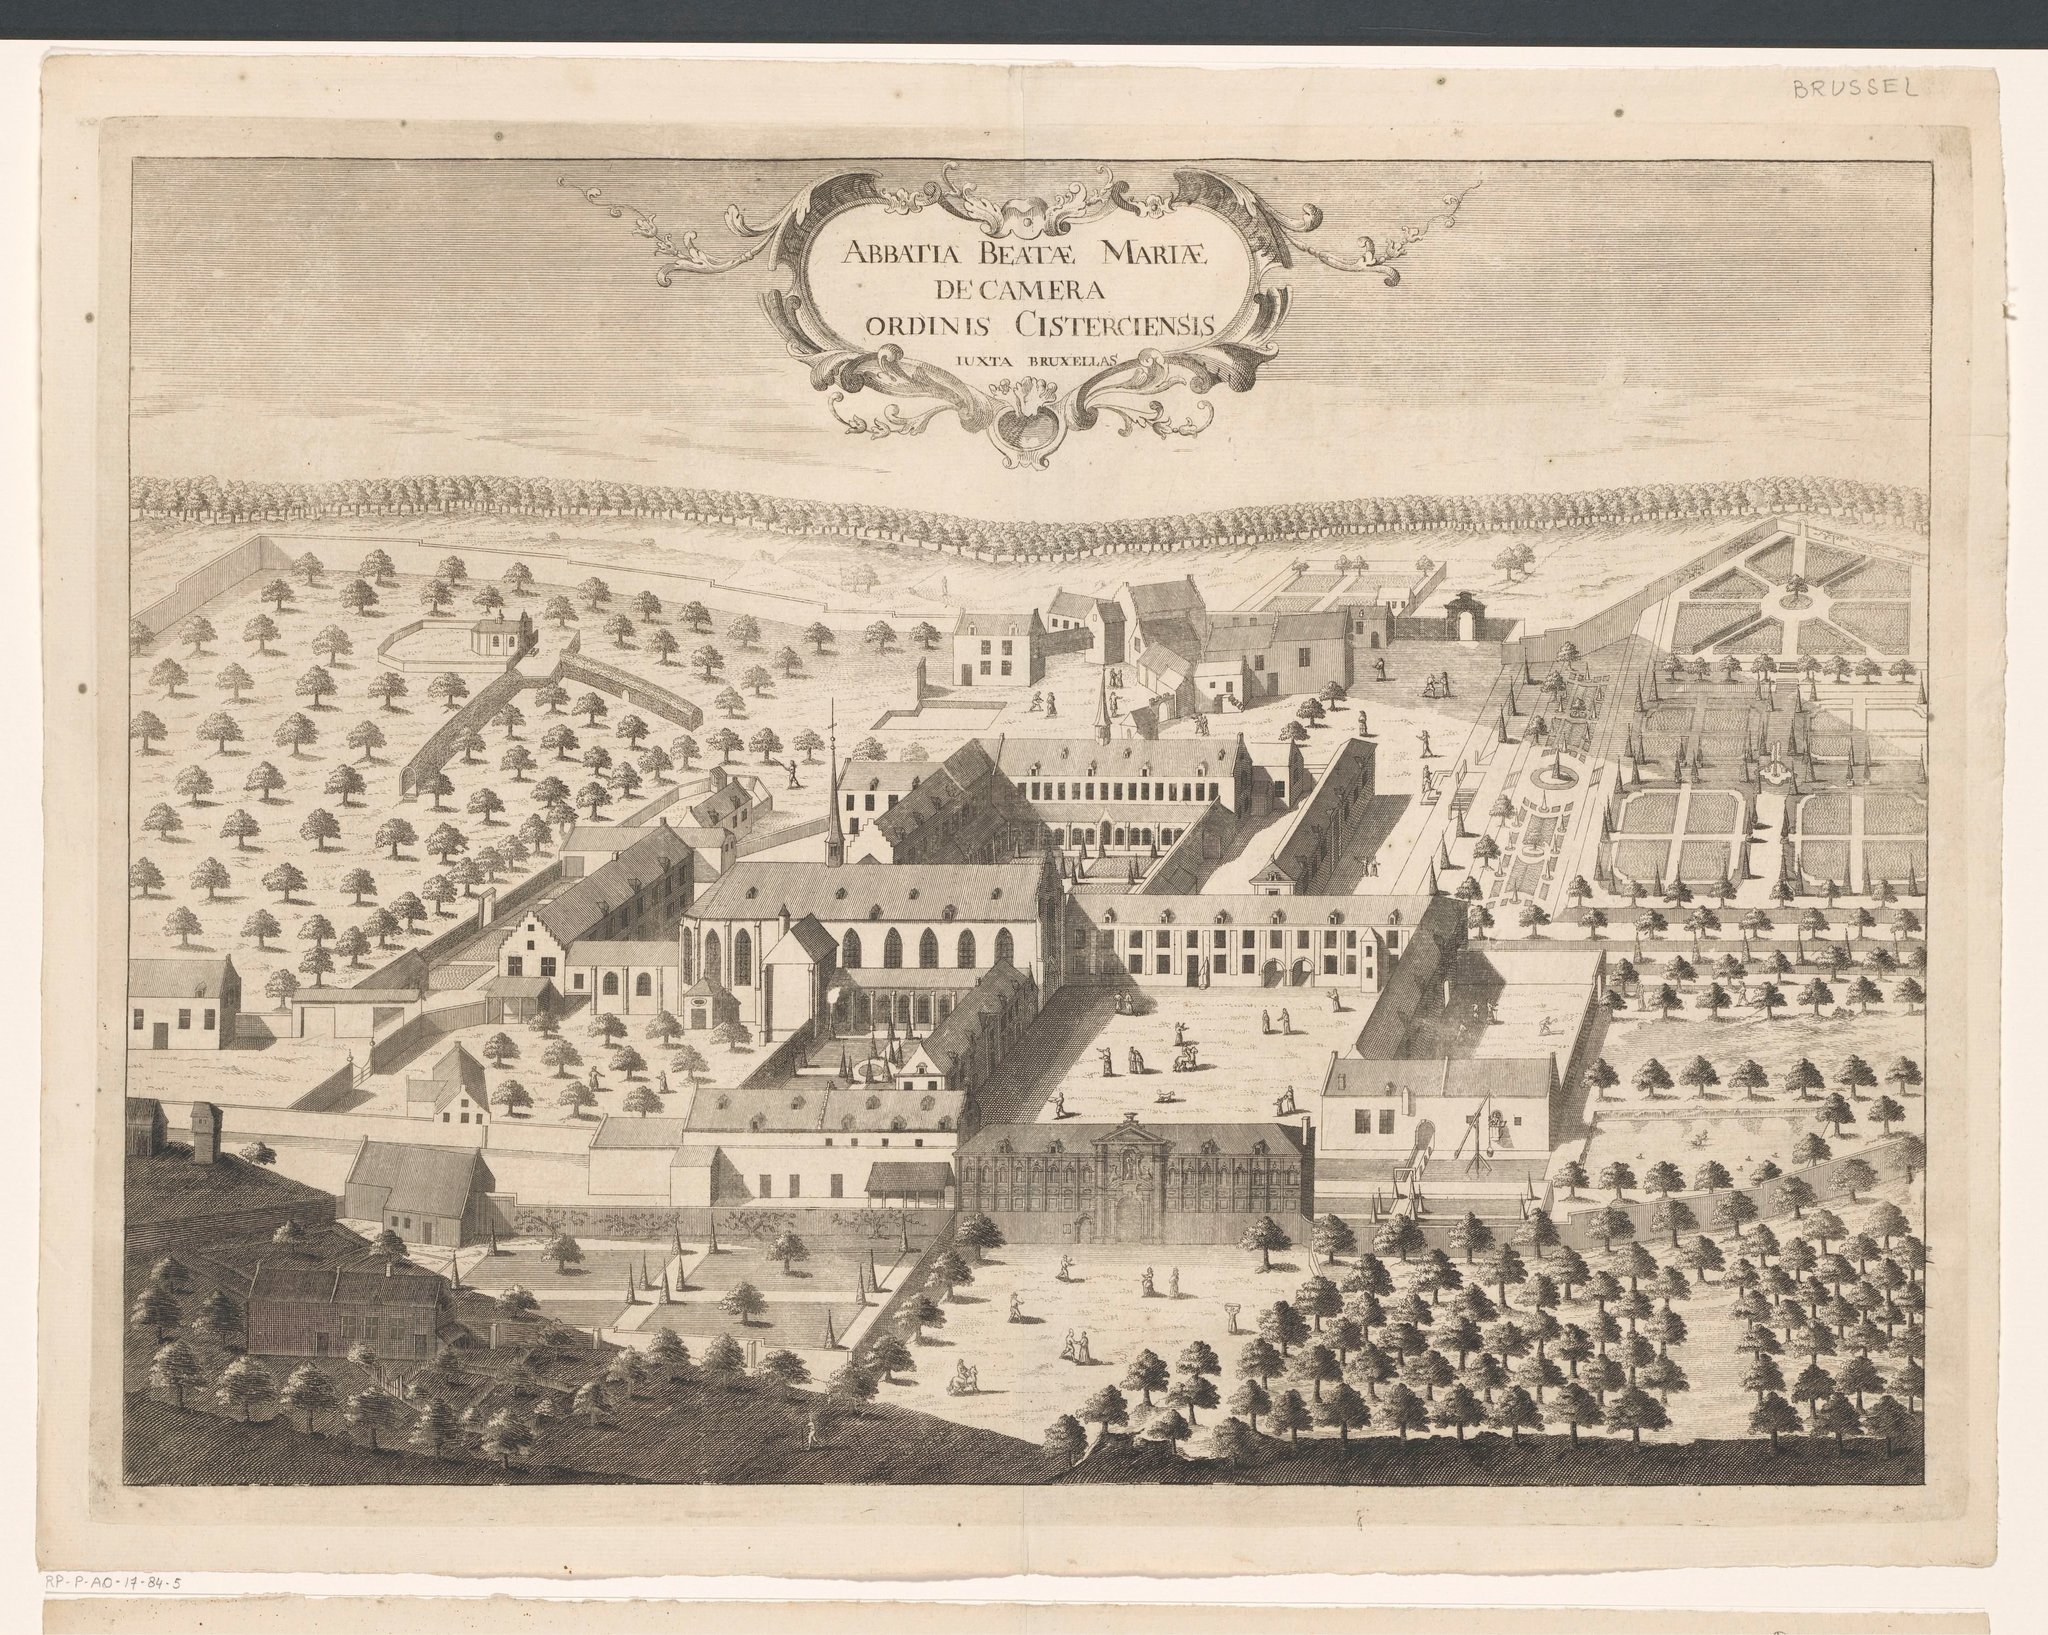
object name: print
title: Abbatia Beatae Mariae de Camera ordinis Cisterciensis iuxta Bruxellas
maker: Anonymous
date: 1726-1734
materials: paper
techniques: engraving, etching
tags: abbey, monastery, convent ~ roman catholic church, abbey garden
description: Prent ook gebruikt in: Sanderus, Antonius. Groot kerkelyk toneel des Hertogdoms van Brabant (...). Den Haag: Christiaan van Lom, 1727. En in: Sanderus, Antonius. Antonii Sanderi presbyteri Chorographia sacra Brabantiæ. 3 delen. Den Haag: Christiaan van Lom, 1726-1727, dl. 1 (1726). En in: Sanderus, Antonius. Le grand theatre sacré du duché de Brabant (...). 4 delen. Den Haag: Gerard Block, 1729-1734.